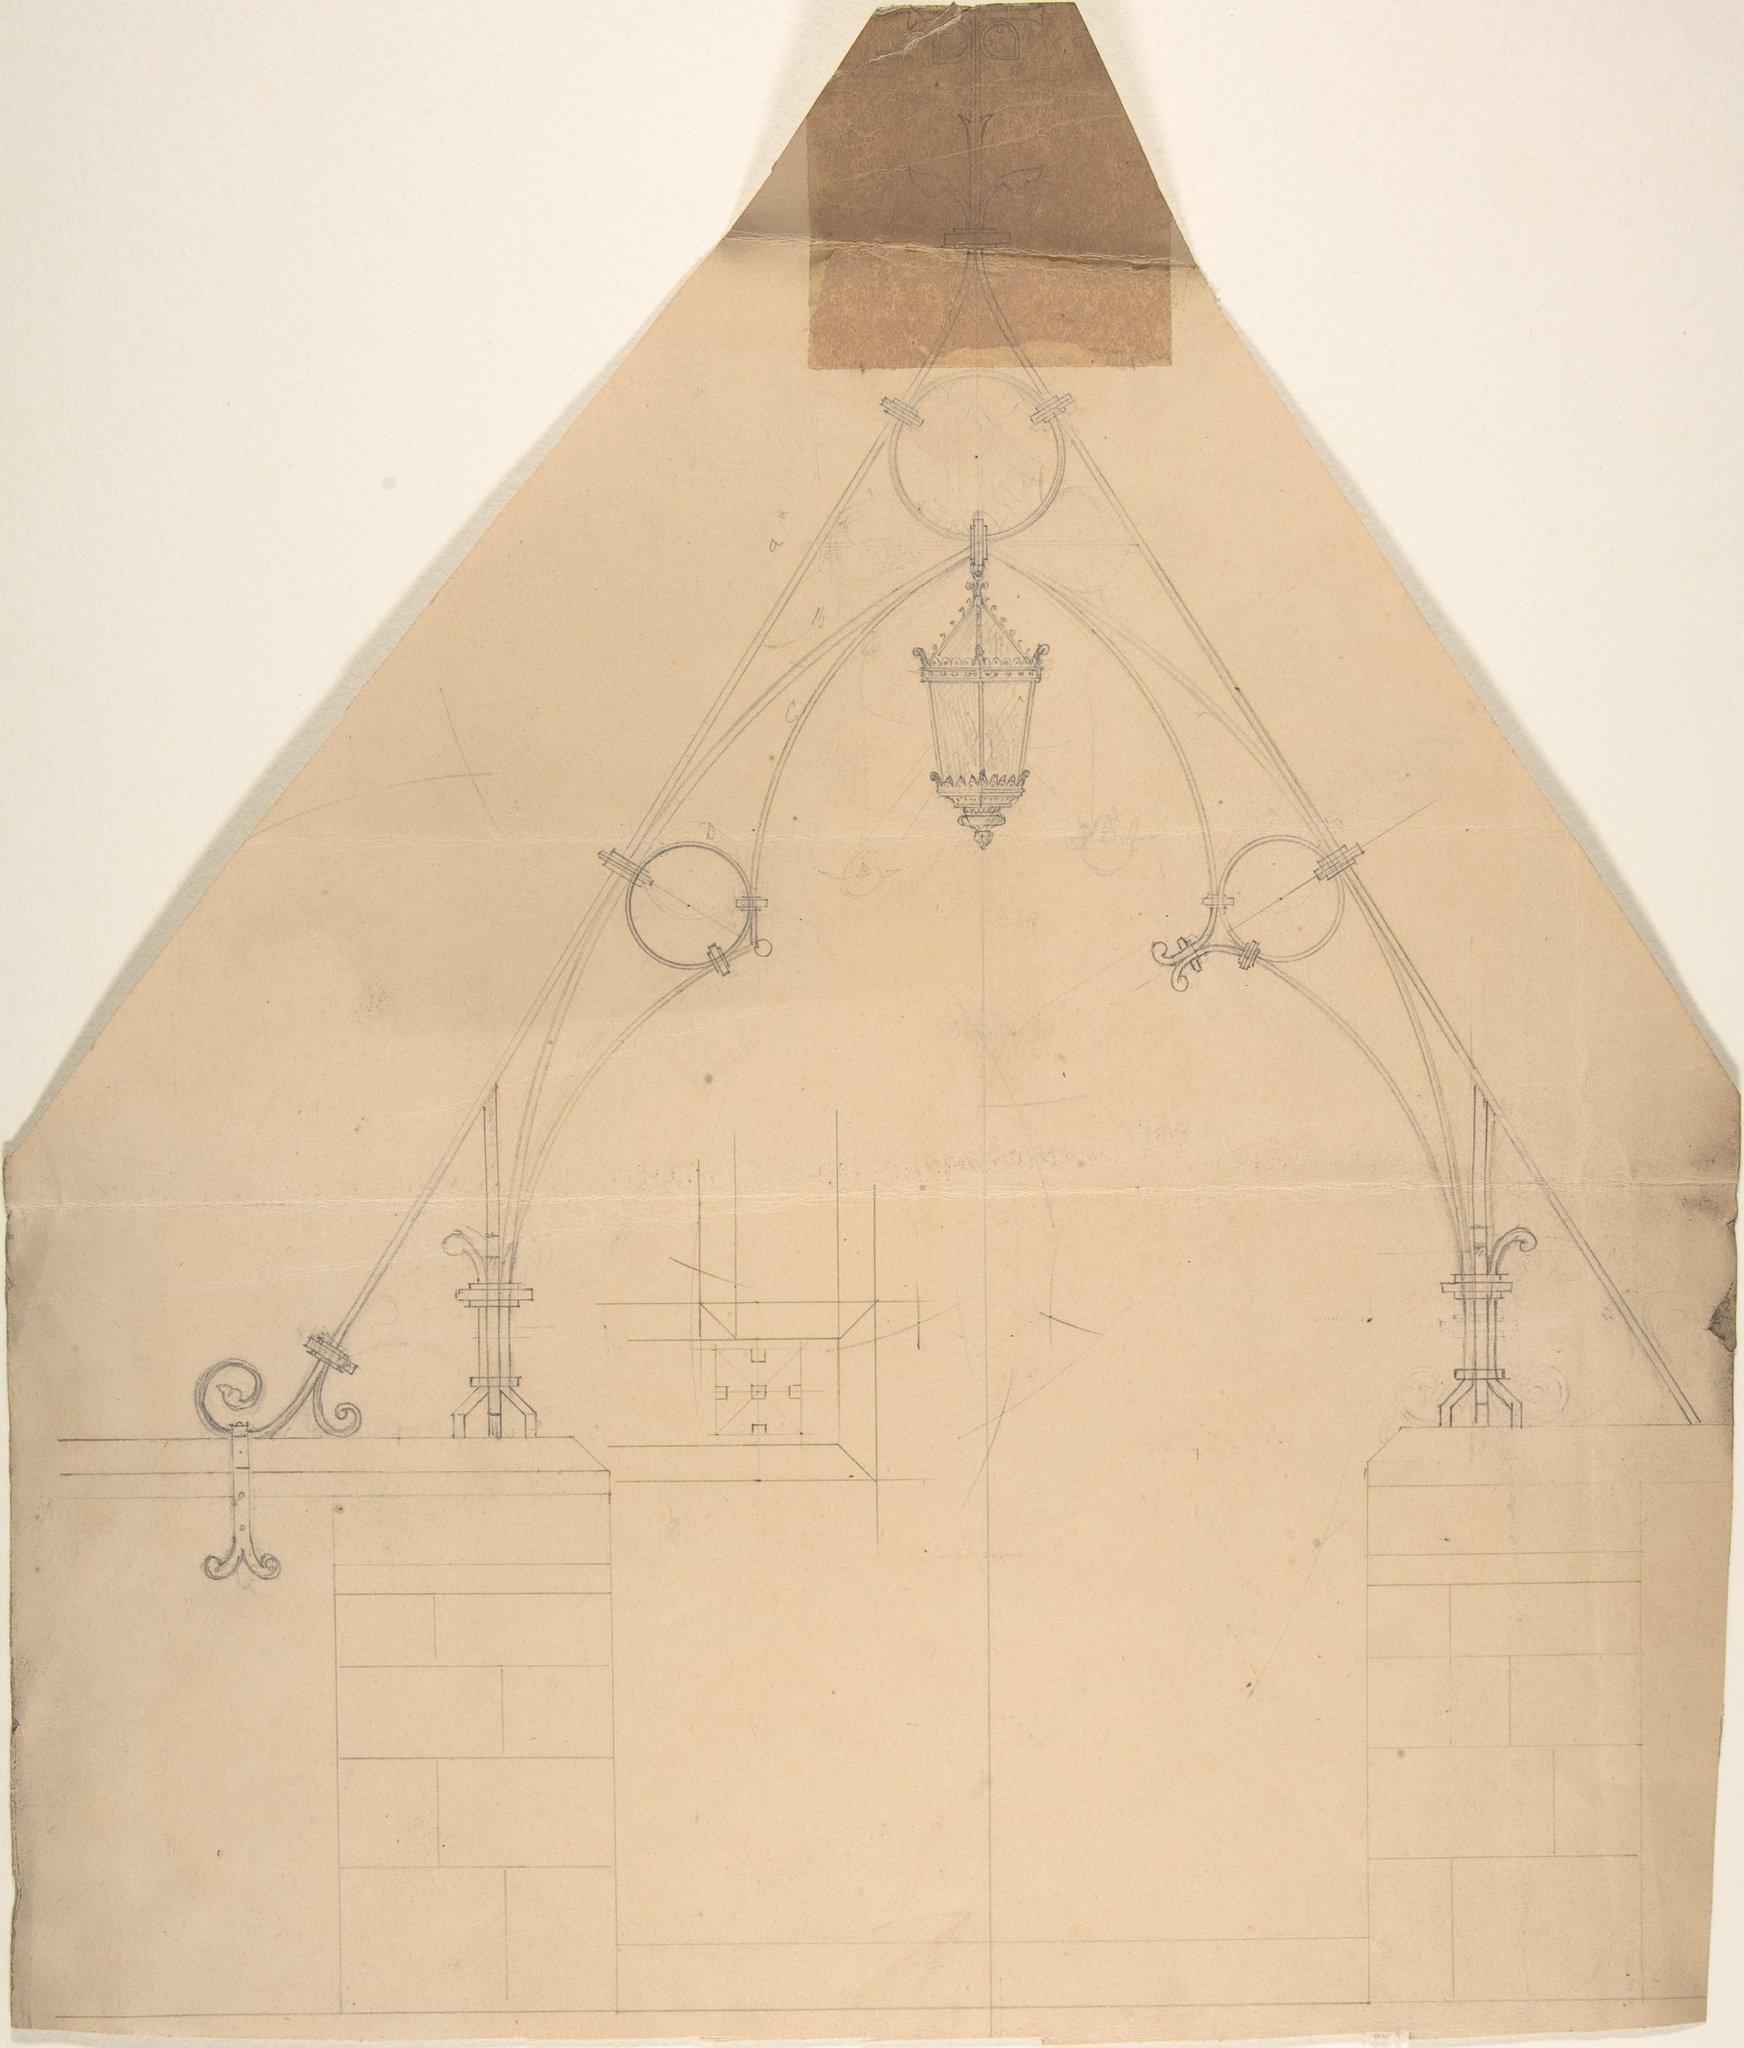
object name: drawing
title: Design for Metalwork Supporting Church Ceiling and Suspended Lantern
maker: anonymous, british, 19th century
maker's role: artist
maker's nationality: british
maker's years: 1800-1900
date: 1880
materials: graphite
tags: architecture